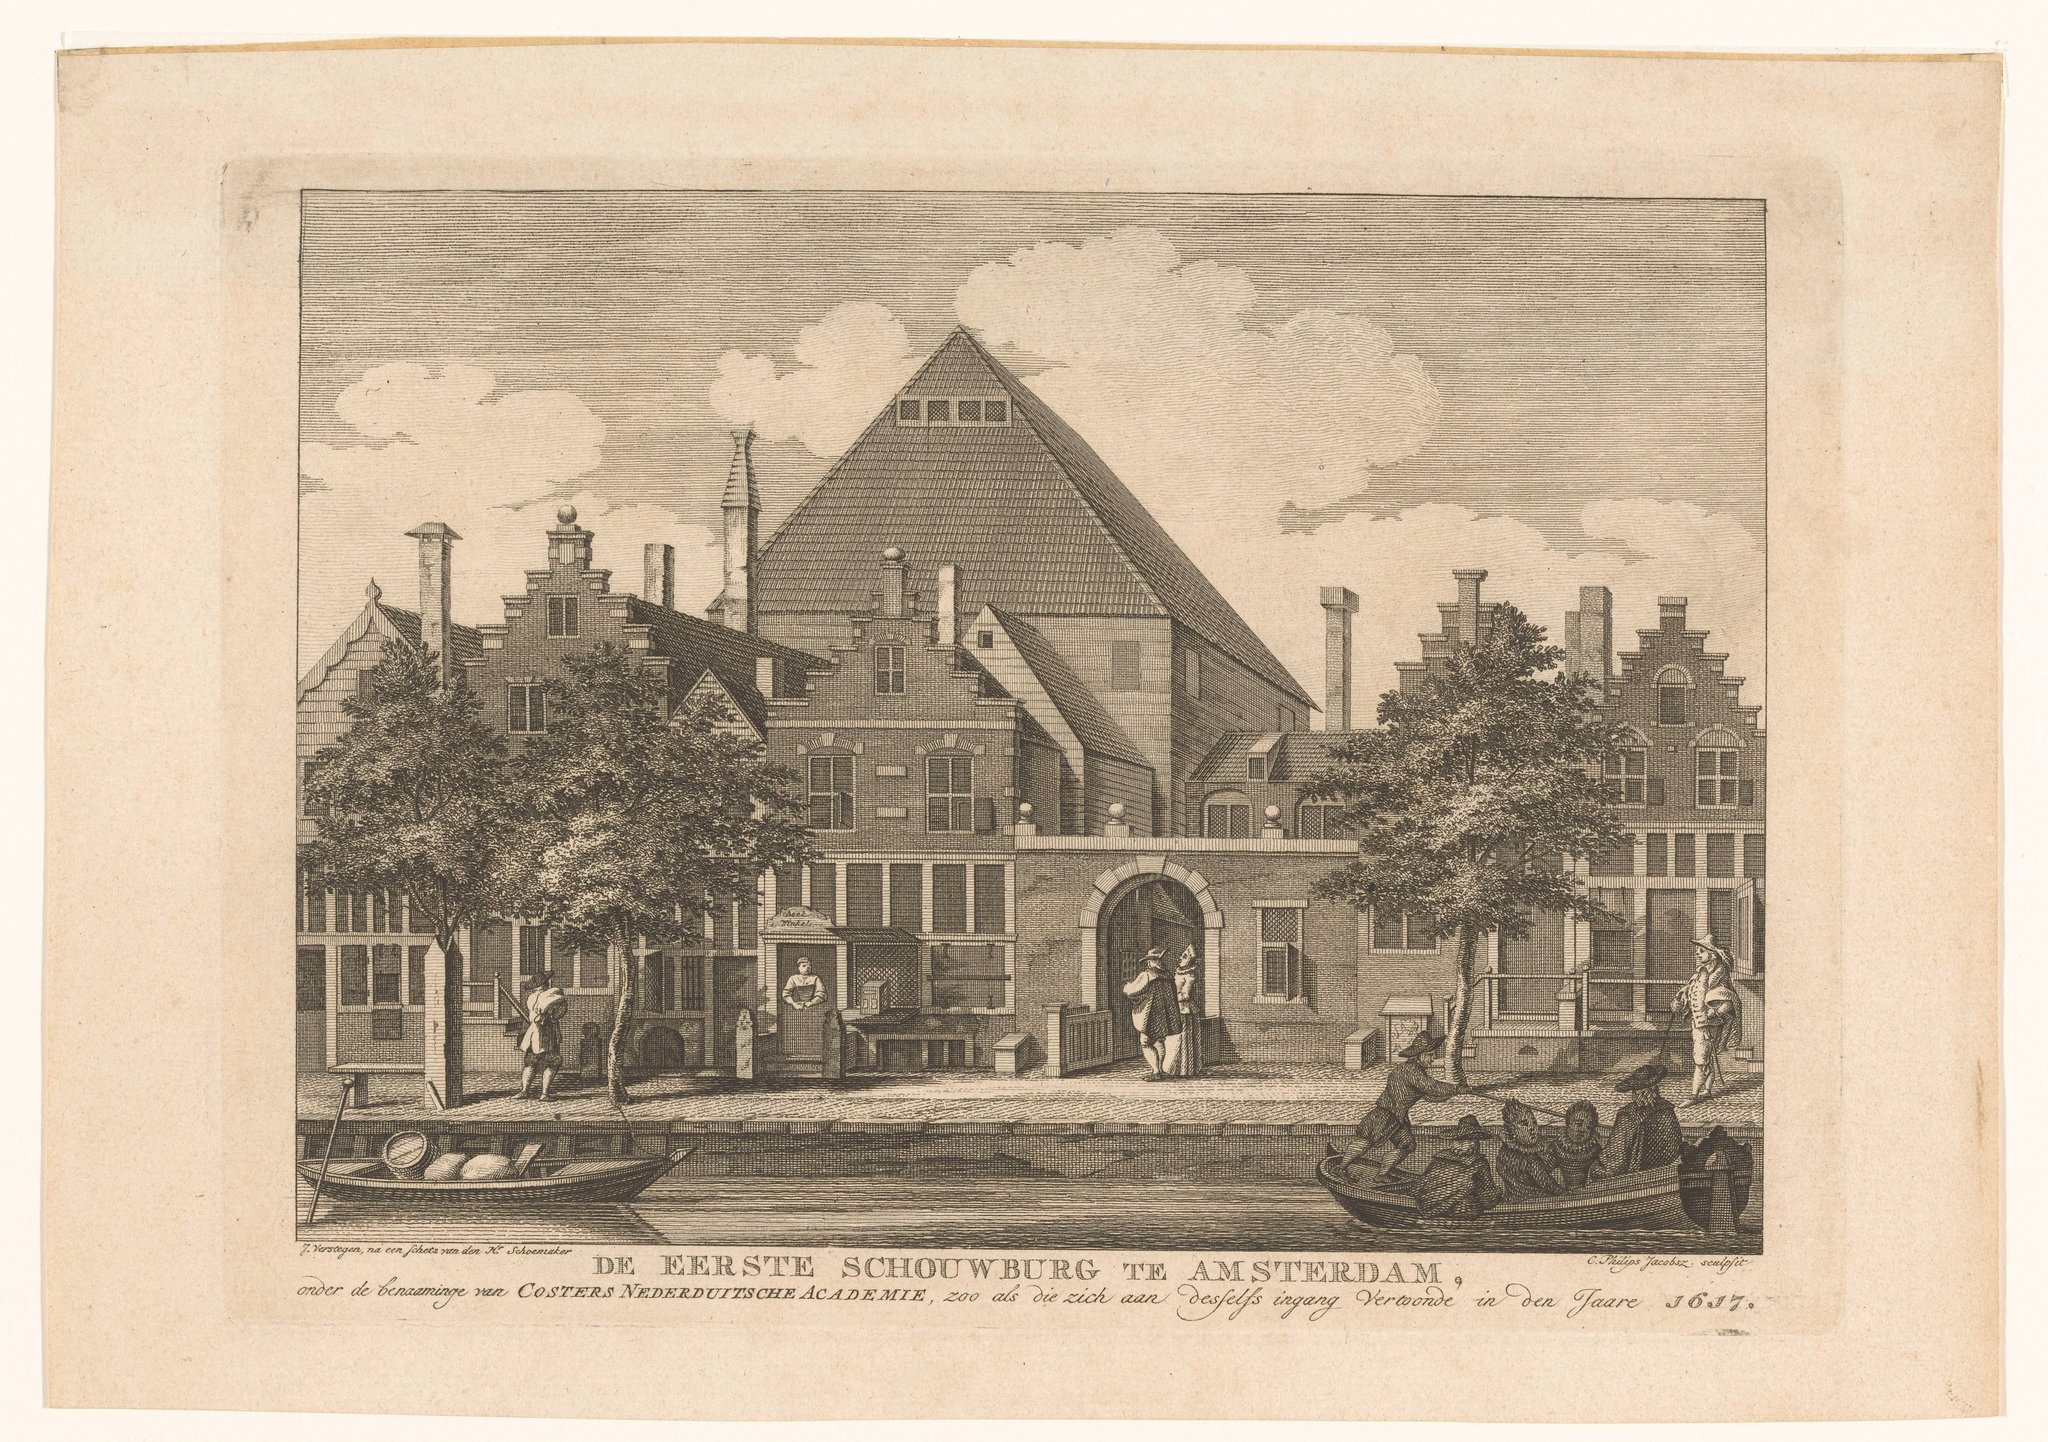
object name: print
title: Gezicht op de Nederduitse Academie van Samuel Coster aan de Keizersgracht, 1617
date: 1752-1789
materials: paper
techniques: engraving, etching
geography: amsterdam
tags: samuel coster, theatre (building), canals, waters (in city) (+ city(-scape) with figures, staffage), street (+ city(-scape) with figures, staffage), book-shop, bookseller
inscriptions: collector's mark: Lugt 195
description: Gezicht op de Nederduitse Academie (Eerste Nederduytsche Academie) van Samuel Coster aan de Keizersgracht te Amsterdam, gelegen ter hoogte van het huidige nummer 384. Zoals het eruit zou hebben gezien in het jaar van oprichting 1617. Links van de toegangspoort een boekwinkel. Op straat en in het bootje rechtsvoor enkele figuren.